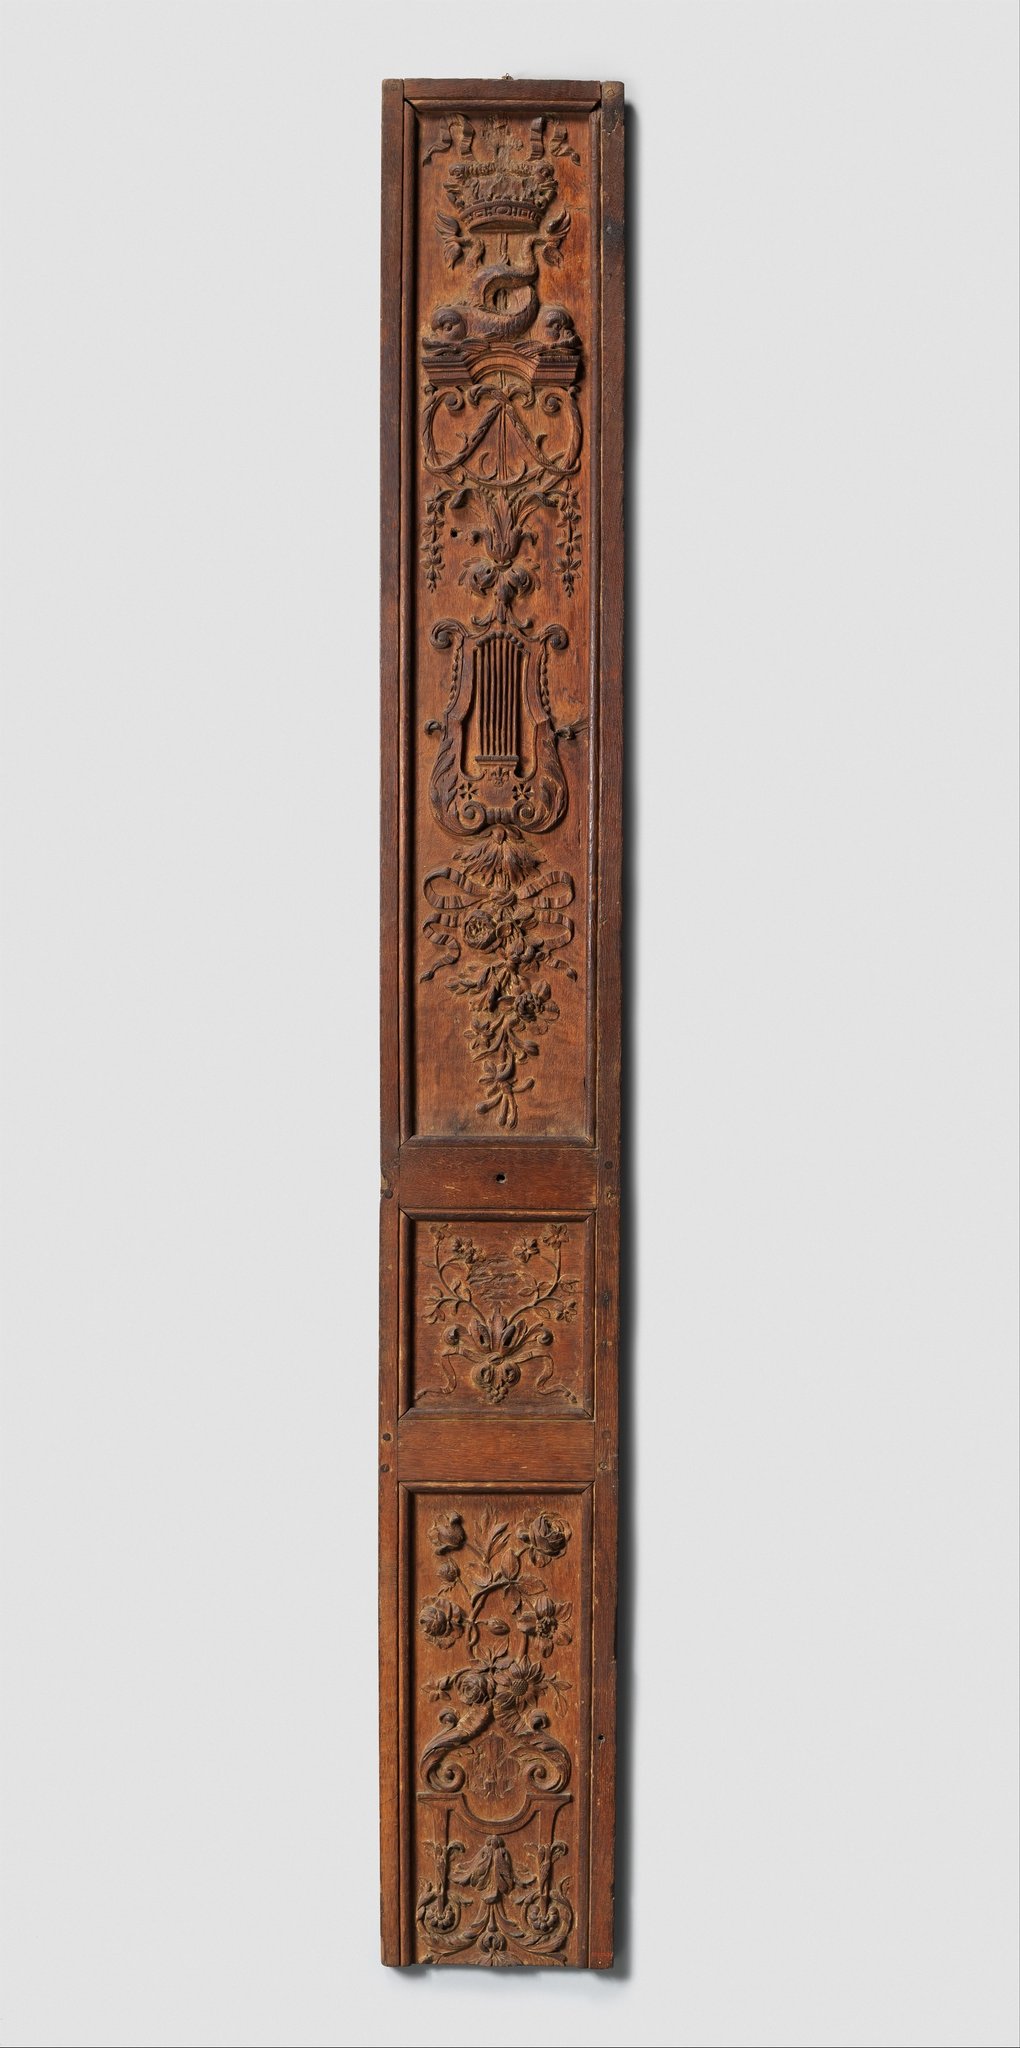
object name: pilaster panel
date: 1700-1710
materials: wood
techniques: carving, painting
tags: fish,flowers,leaves,coat of arms